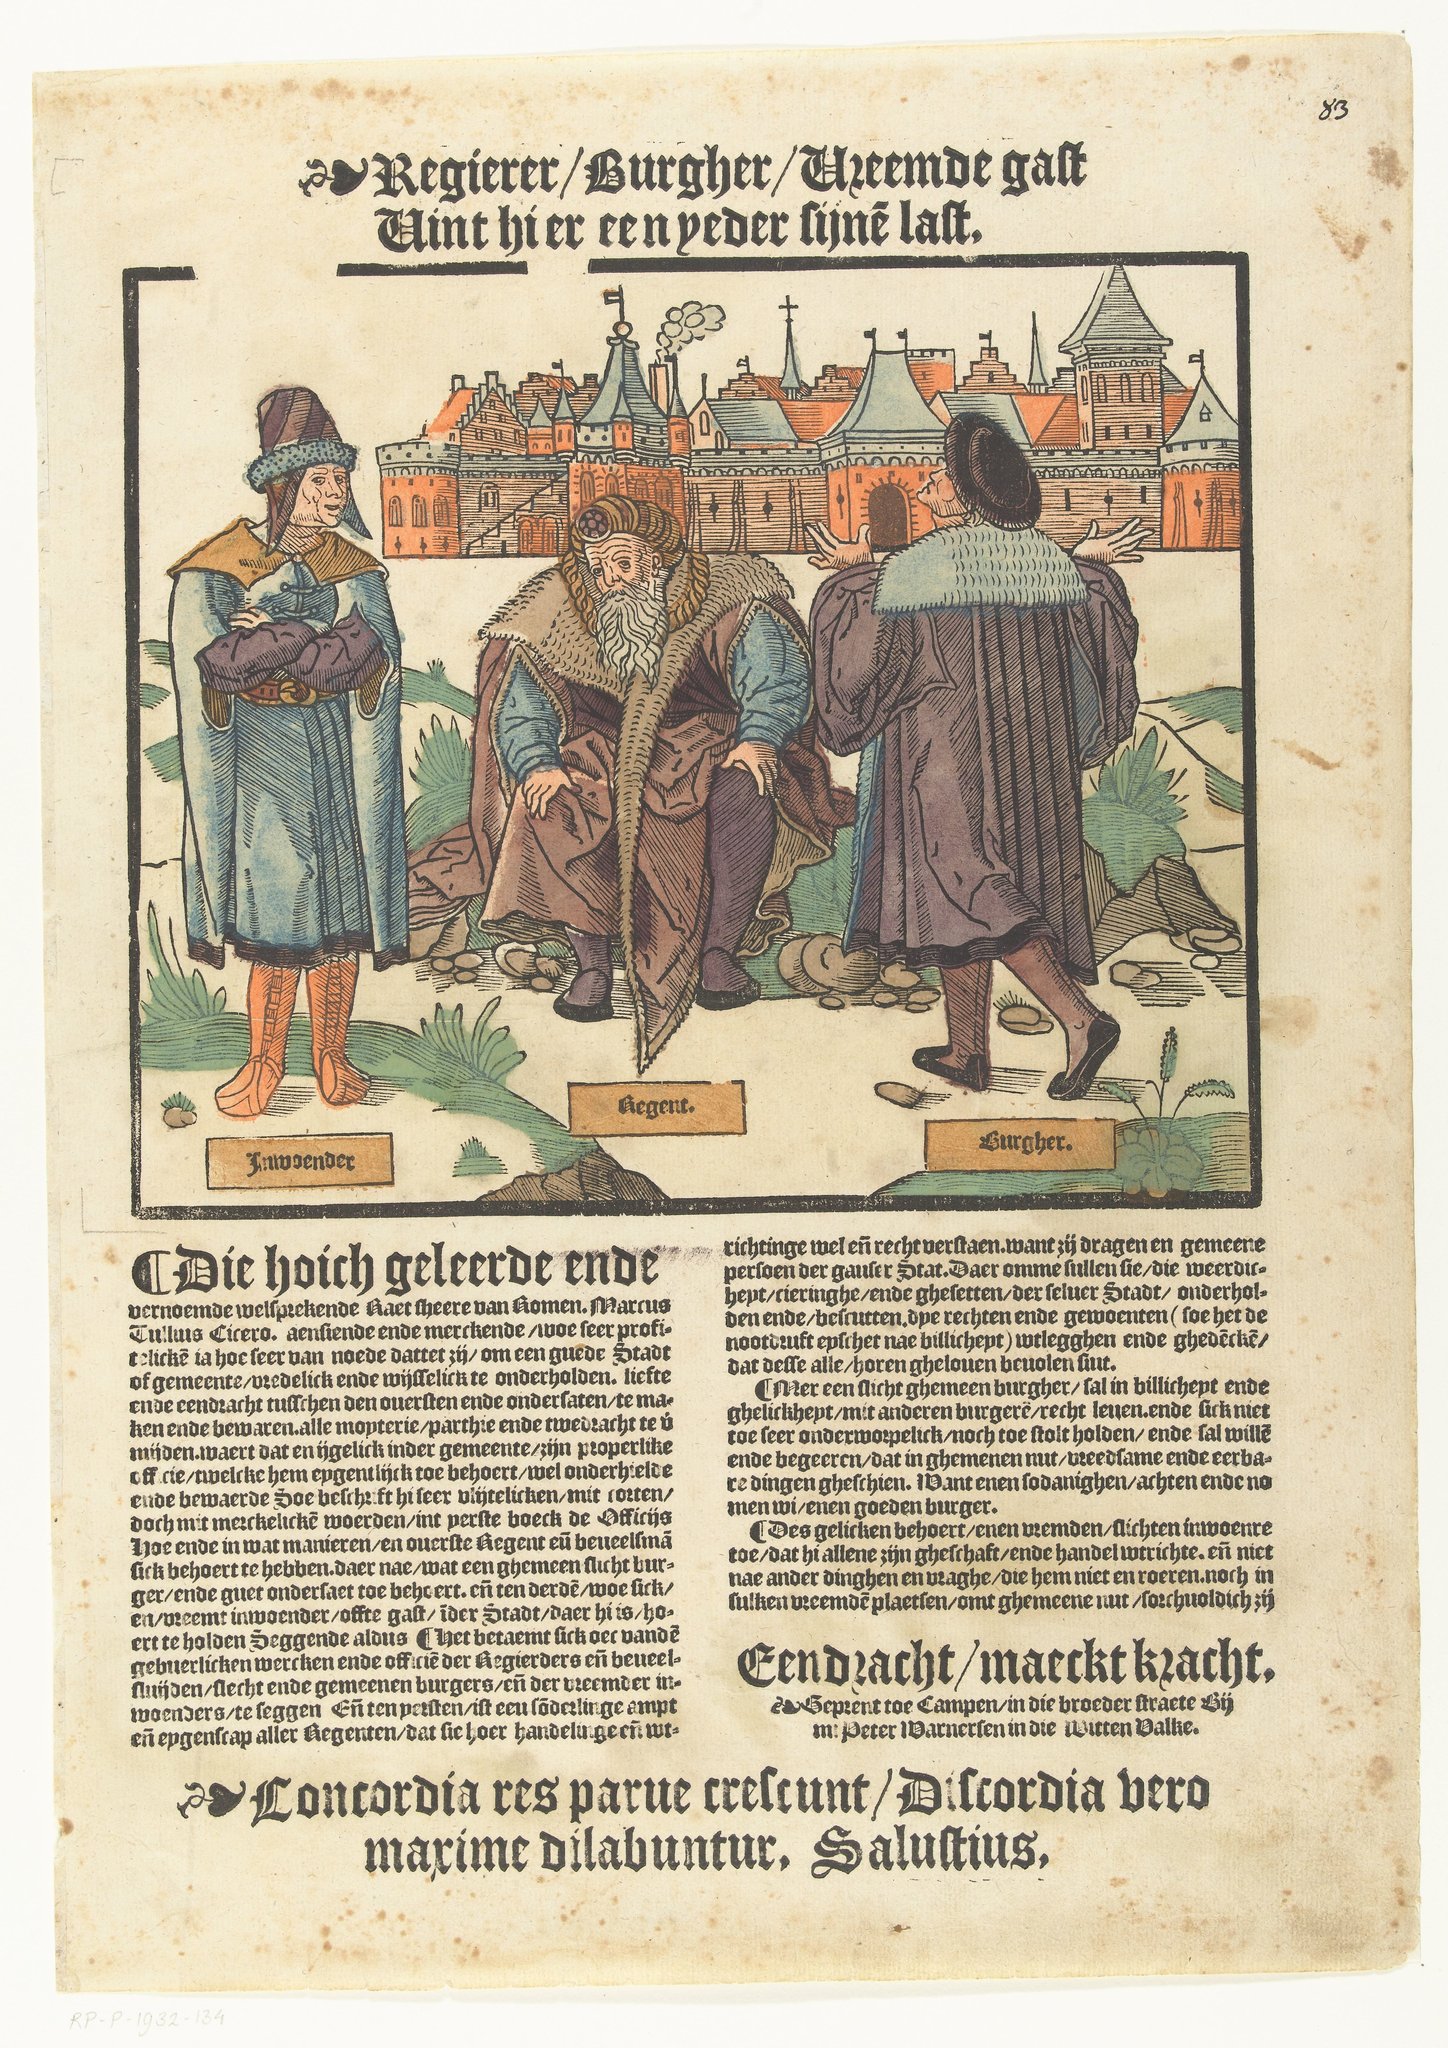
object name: print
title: Regierer/Burgher/Vreemde gast Vint hier een yeder sijne[n] last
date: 1540-1567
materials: paper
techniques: hand coloring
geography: low countries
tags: agreement, unity; 'concordia', 'concordia insuperabile', 'concordia militare', 'concordia di pace', 'unione civile' (ripa), city-view in general; 'veduta'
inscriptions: number: ‘83’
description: Drie mannen, een vreemde, een regent en een burger, met op de achtergrond een stad. Tekst in het Nederlands.